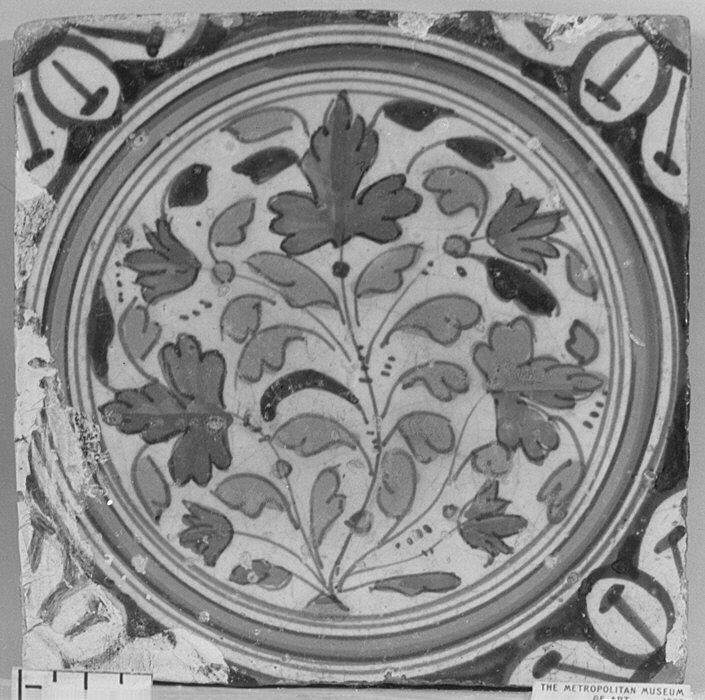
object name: tile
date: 1580-1620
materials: earthenware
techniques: glazing